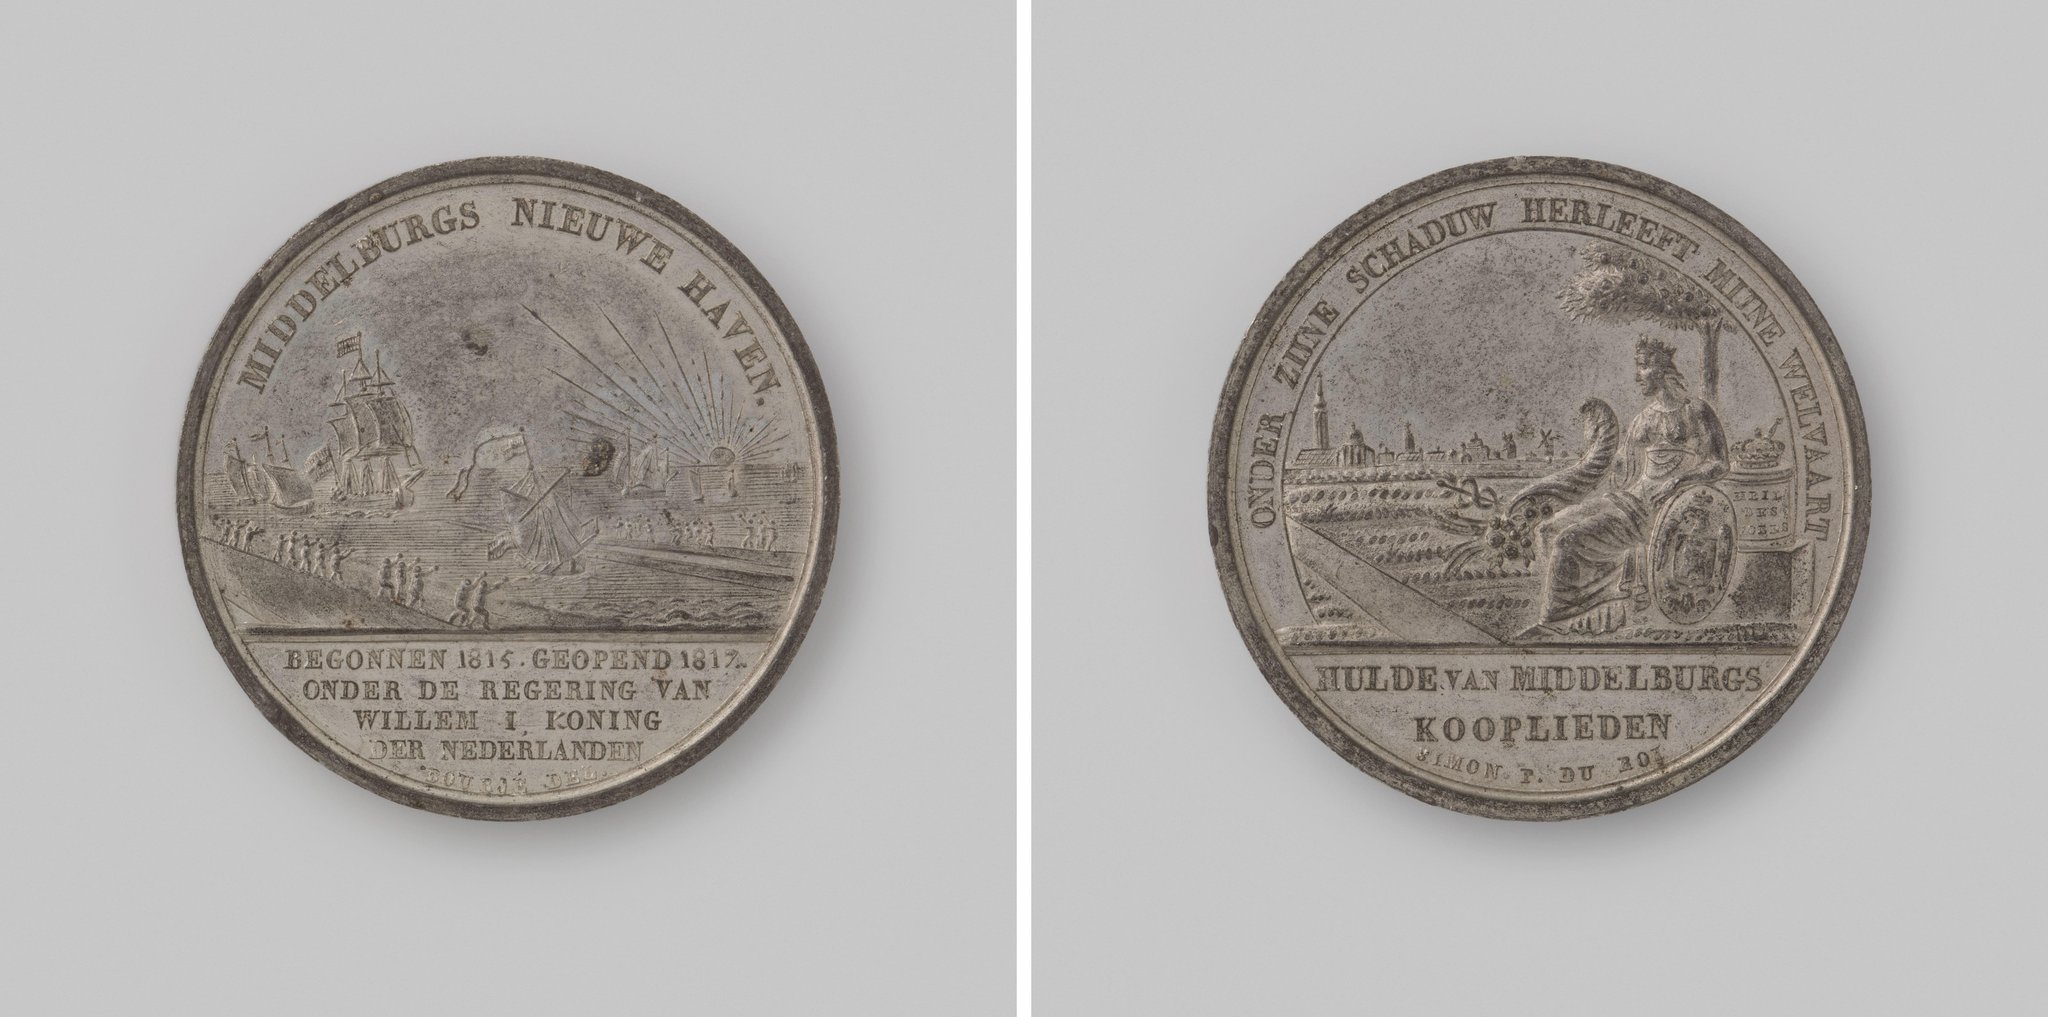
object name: history medal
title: Opening van de nieuwe haven van Middelburg 1817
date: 1817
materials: tin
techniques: striking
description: Tinnen penning, op de voorzijde de stadsgodin van Middelburg, met hoorn des overvloeds en een ovaal stadswapen, getroond onder een oranjeboom, uitziend over het landschap bij de stad, naast een kroon op een beschreven zuil, met omschrift en afsnedetekst, op de keerzijde schepen die langs een juigende menigte een kanaal invaren, onder een opkomende zon, met omschrift en afsnedetekst.